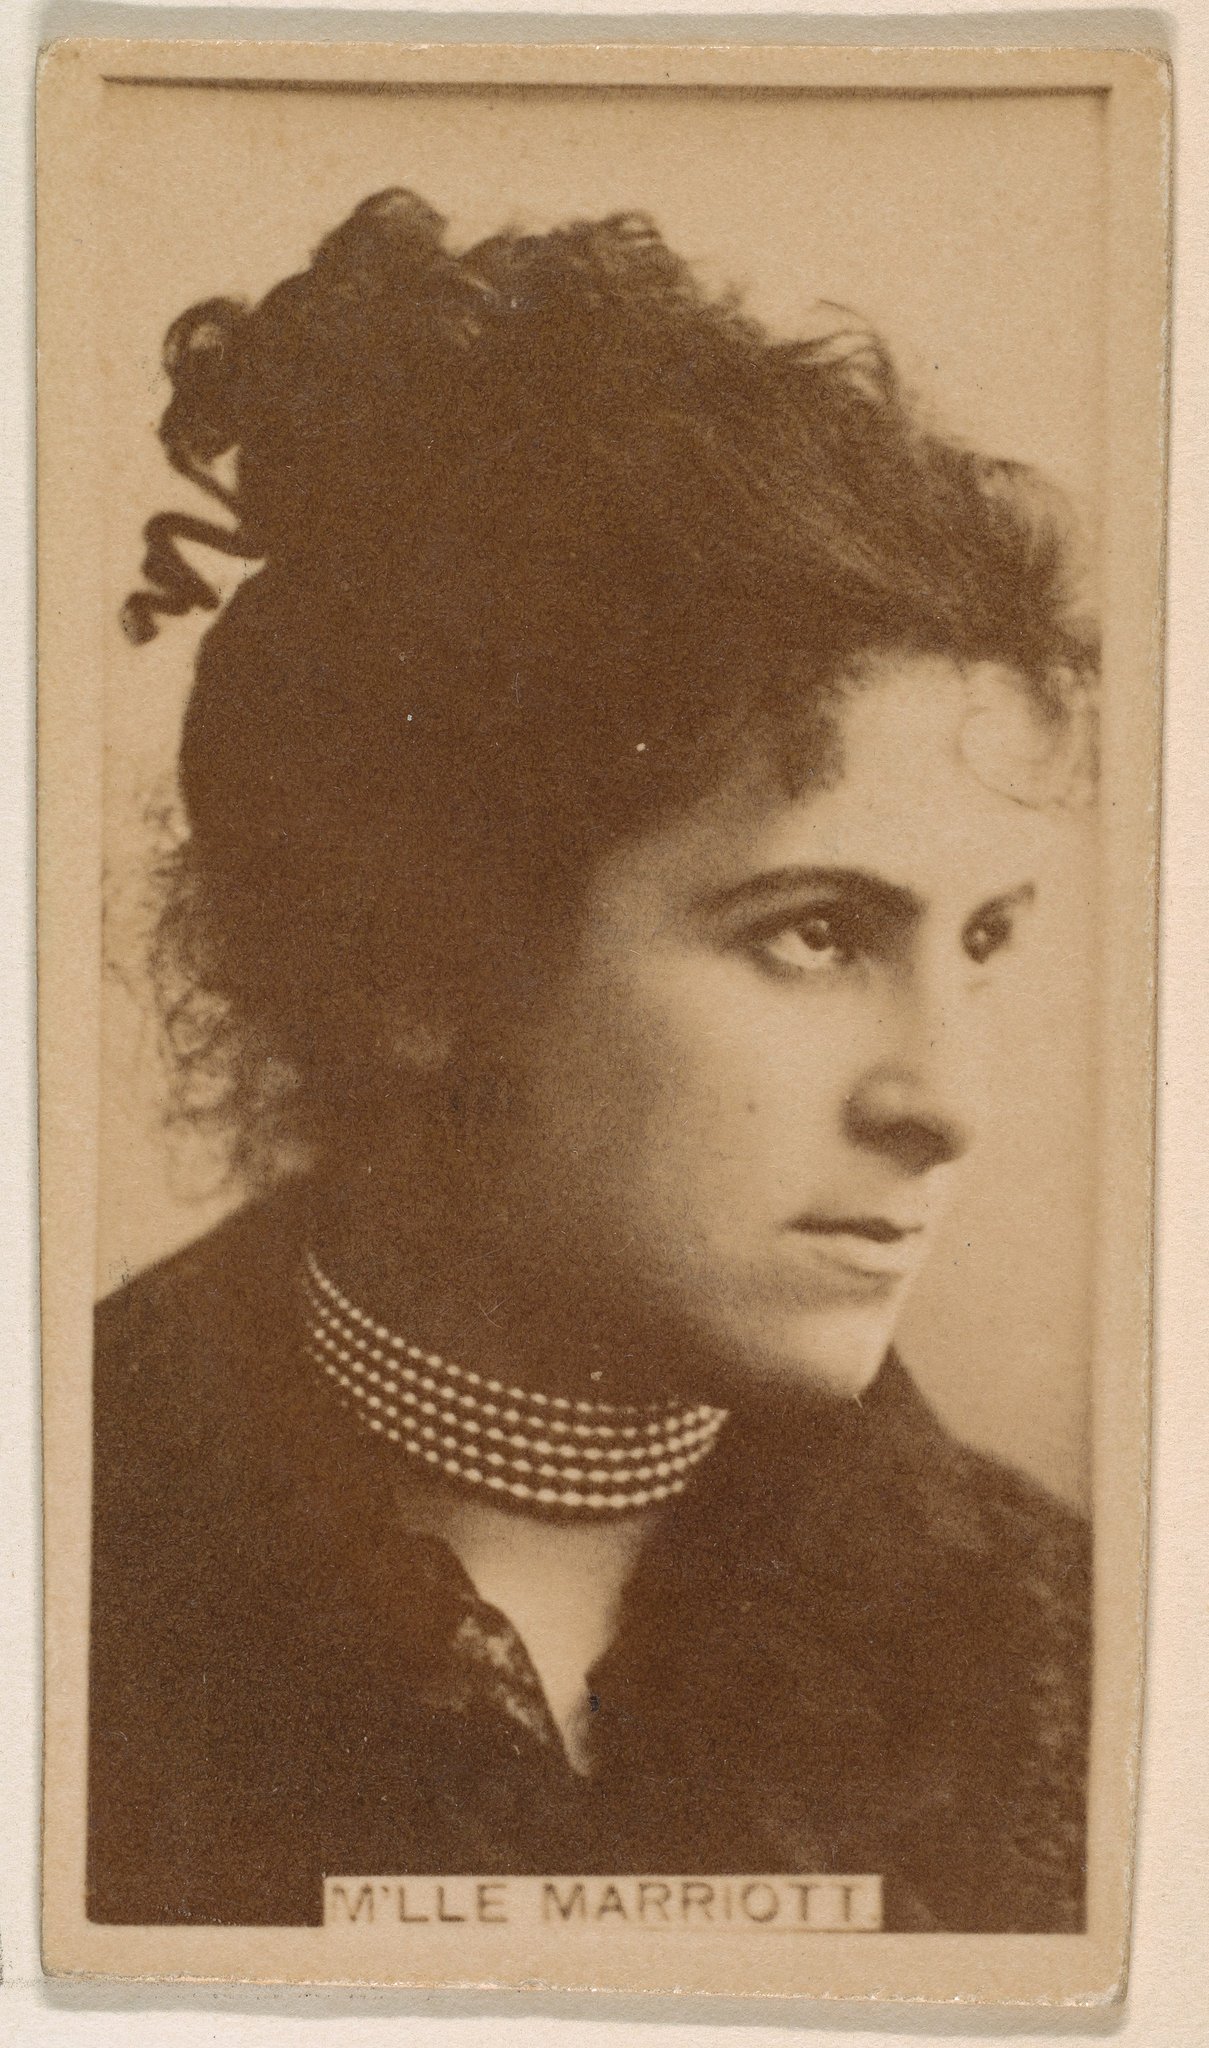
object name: photograph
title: M'lle Marriott, from the Actresses series (N245) issued by Kinney Brothers to promote Sweet Caporal Cigarettes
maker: kinney brothers tobacco company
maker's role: publisher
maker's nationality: american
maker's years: 1869-2011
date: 1890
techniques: albumen silver print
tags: portraits,women,actresses